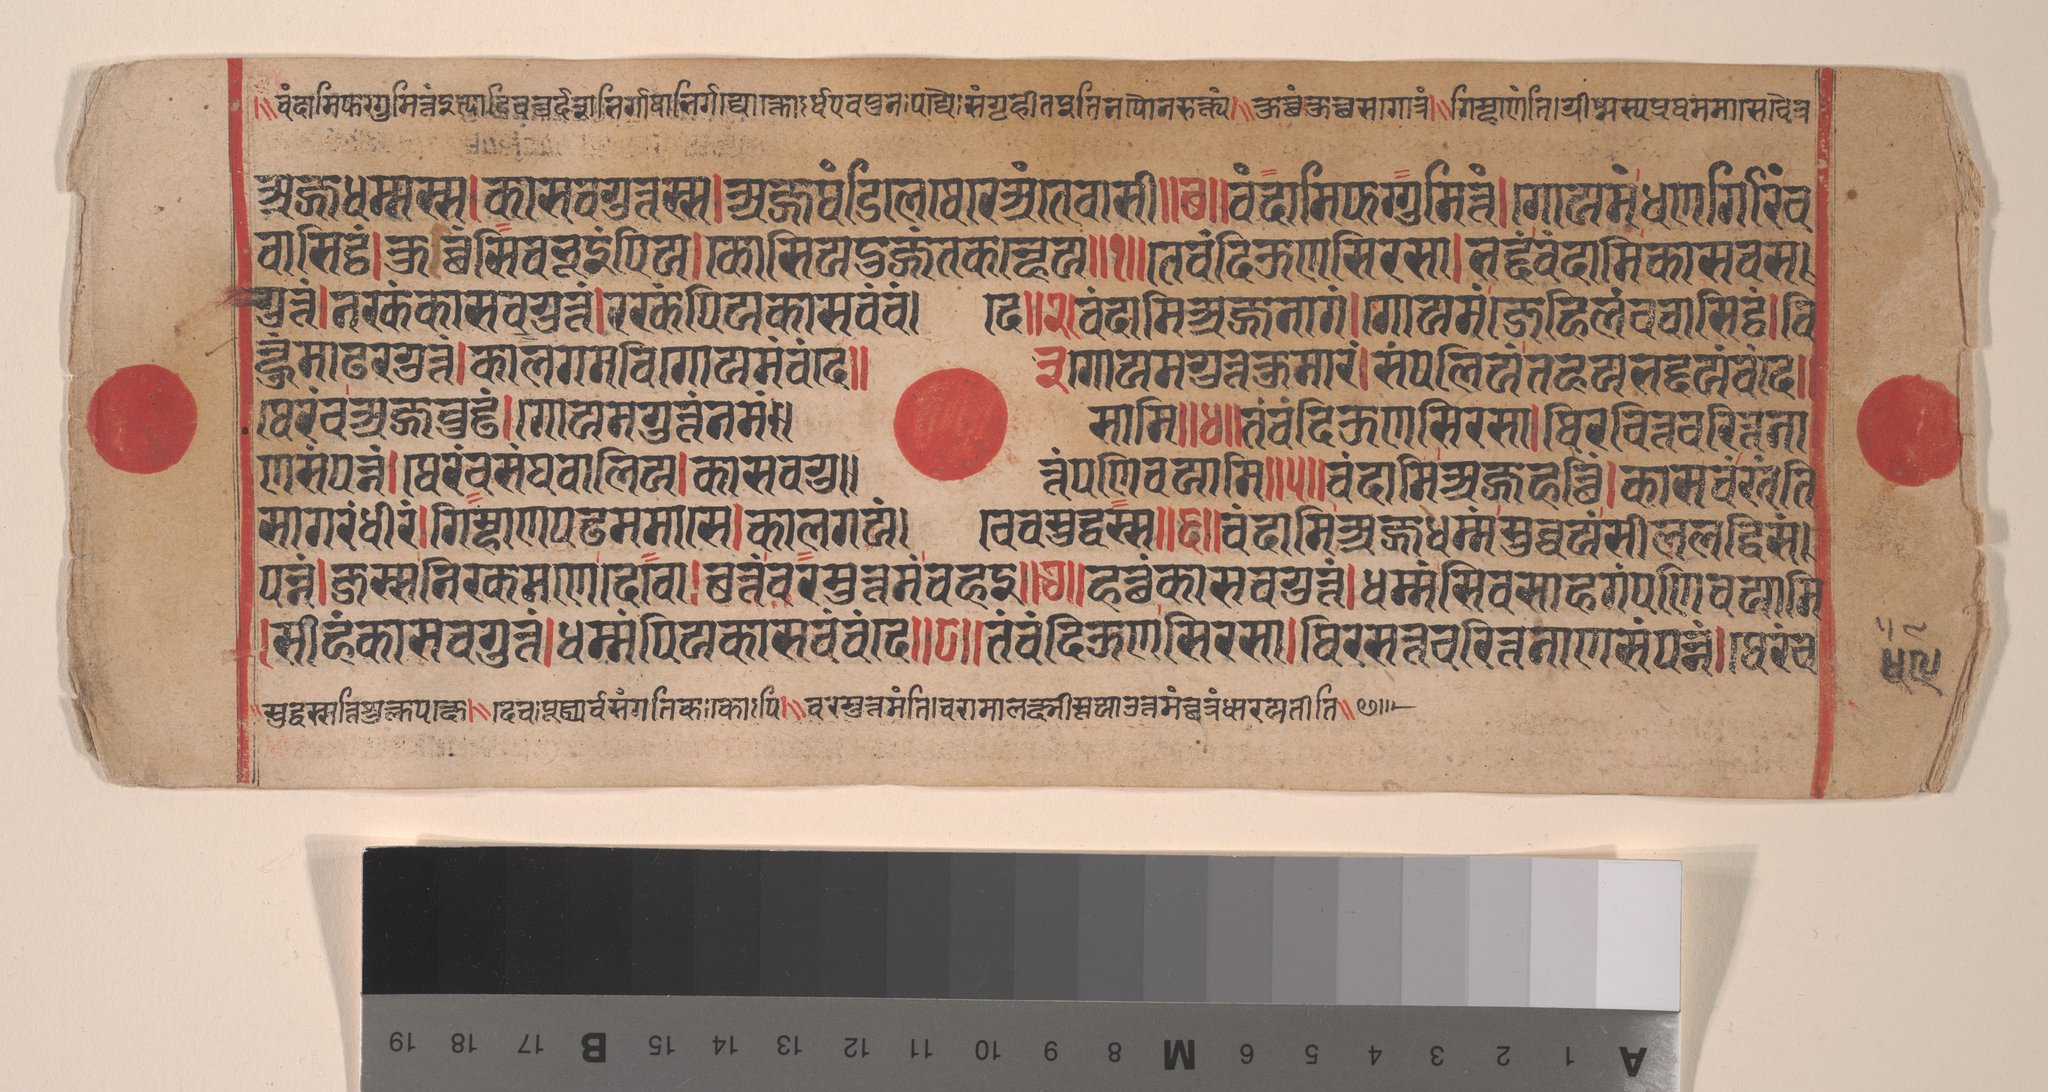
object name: folio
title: Leaf from a Kalpa Sutra (Jain Book of Rituals)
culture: indian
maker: bhadrabahu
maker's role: artist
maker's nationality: indian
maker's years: 356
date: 1401-1500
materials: gold, ink, paper, watercolor